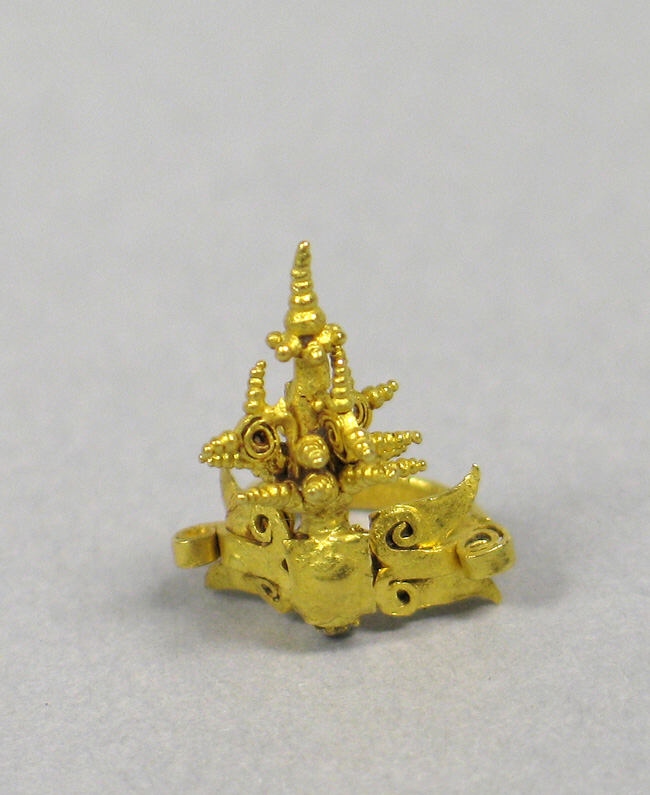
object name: ear clip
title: Ear Clip with Design Composed of Granulation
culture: indonesian, javanese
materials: gold